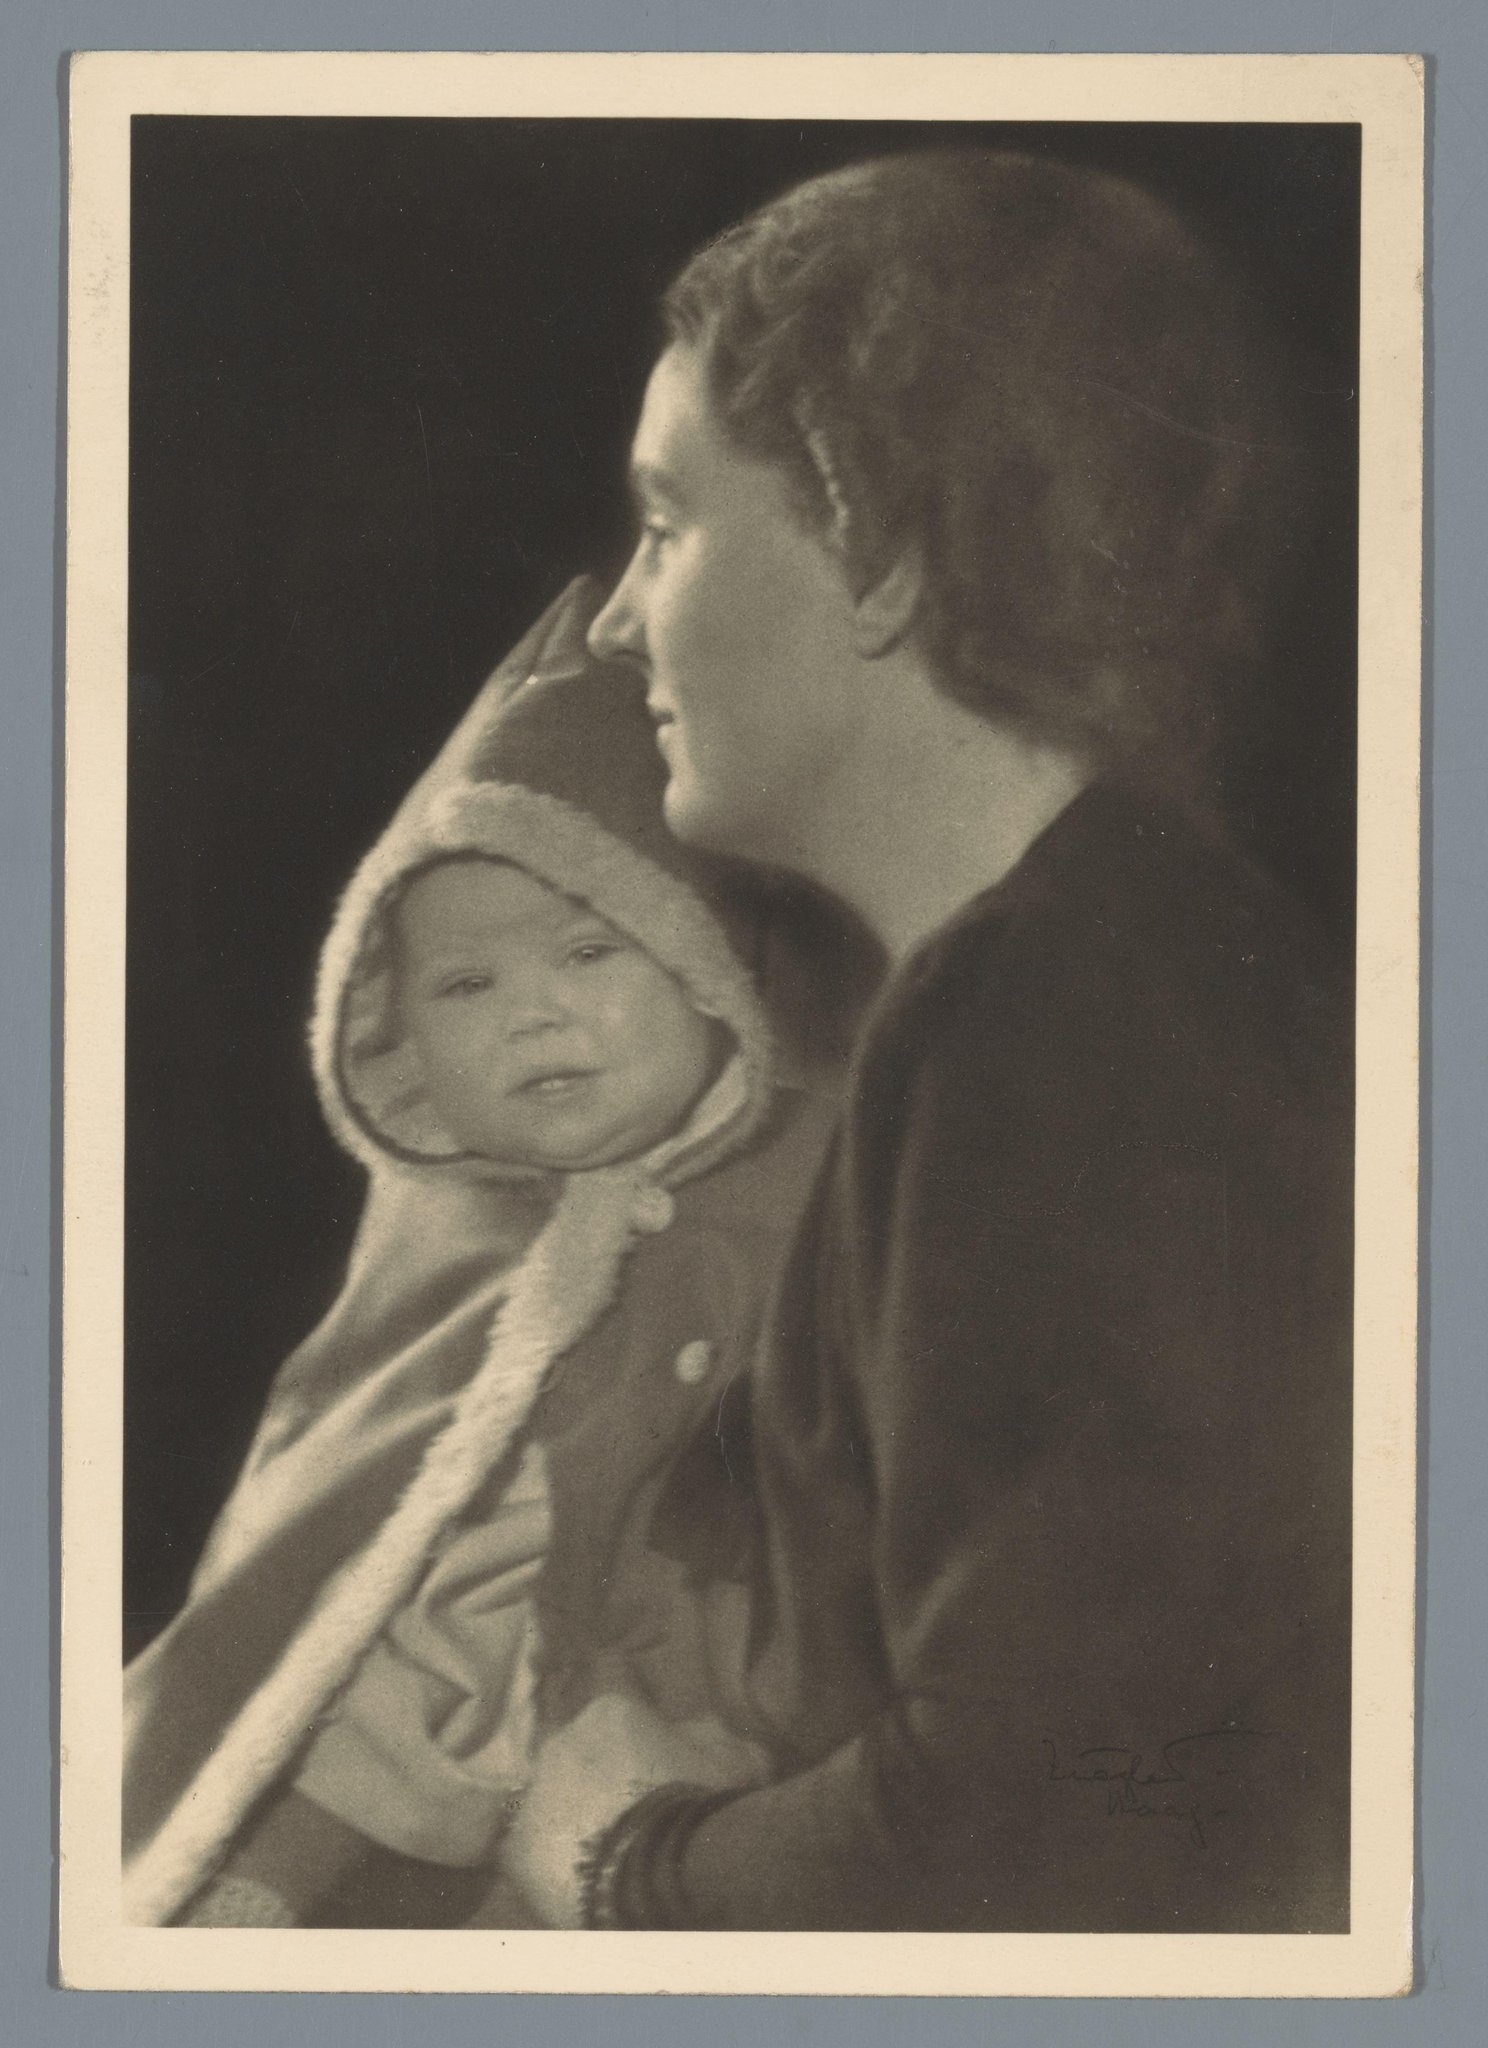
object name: ansichtkaart, prentbriefkaart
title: Kerstmis 1938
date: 1938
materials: photographic support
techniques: gelatin silver print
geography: rotterdam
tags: beatrix (koningin der nederlanden), juliana of the netherlands, crown princess, princess, mother and daughter(s) (family group)